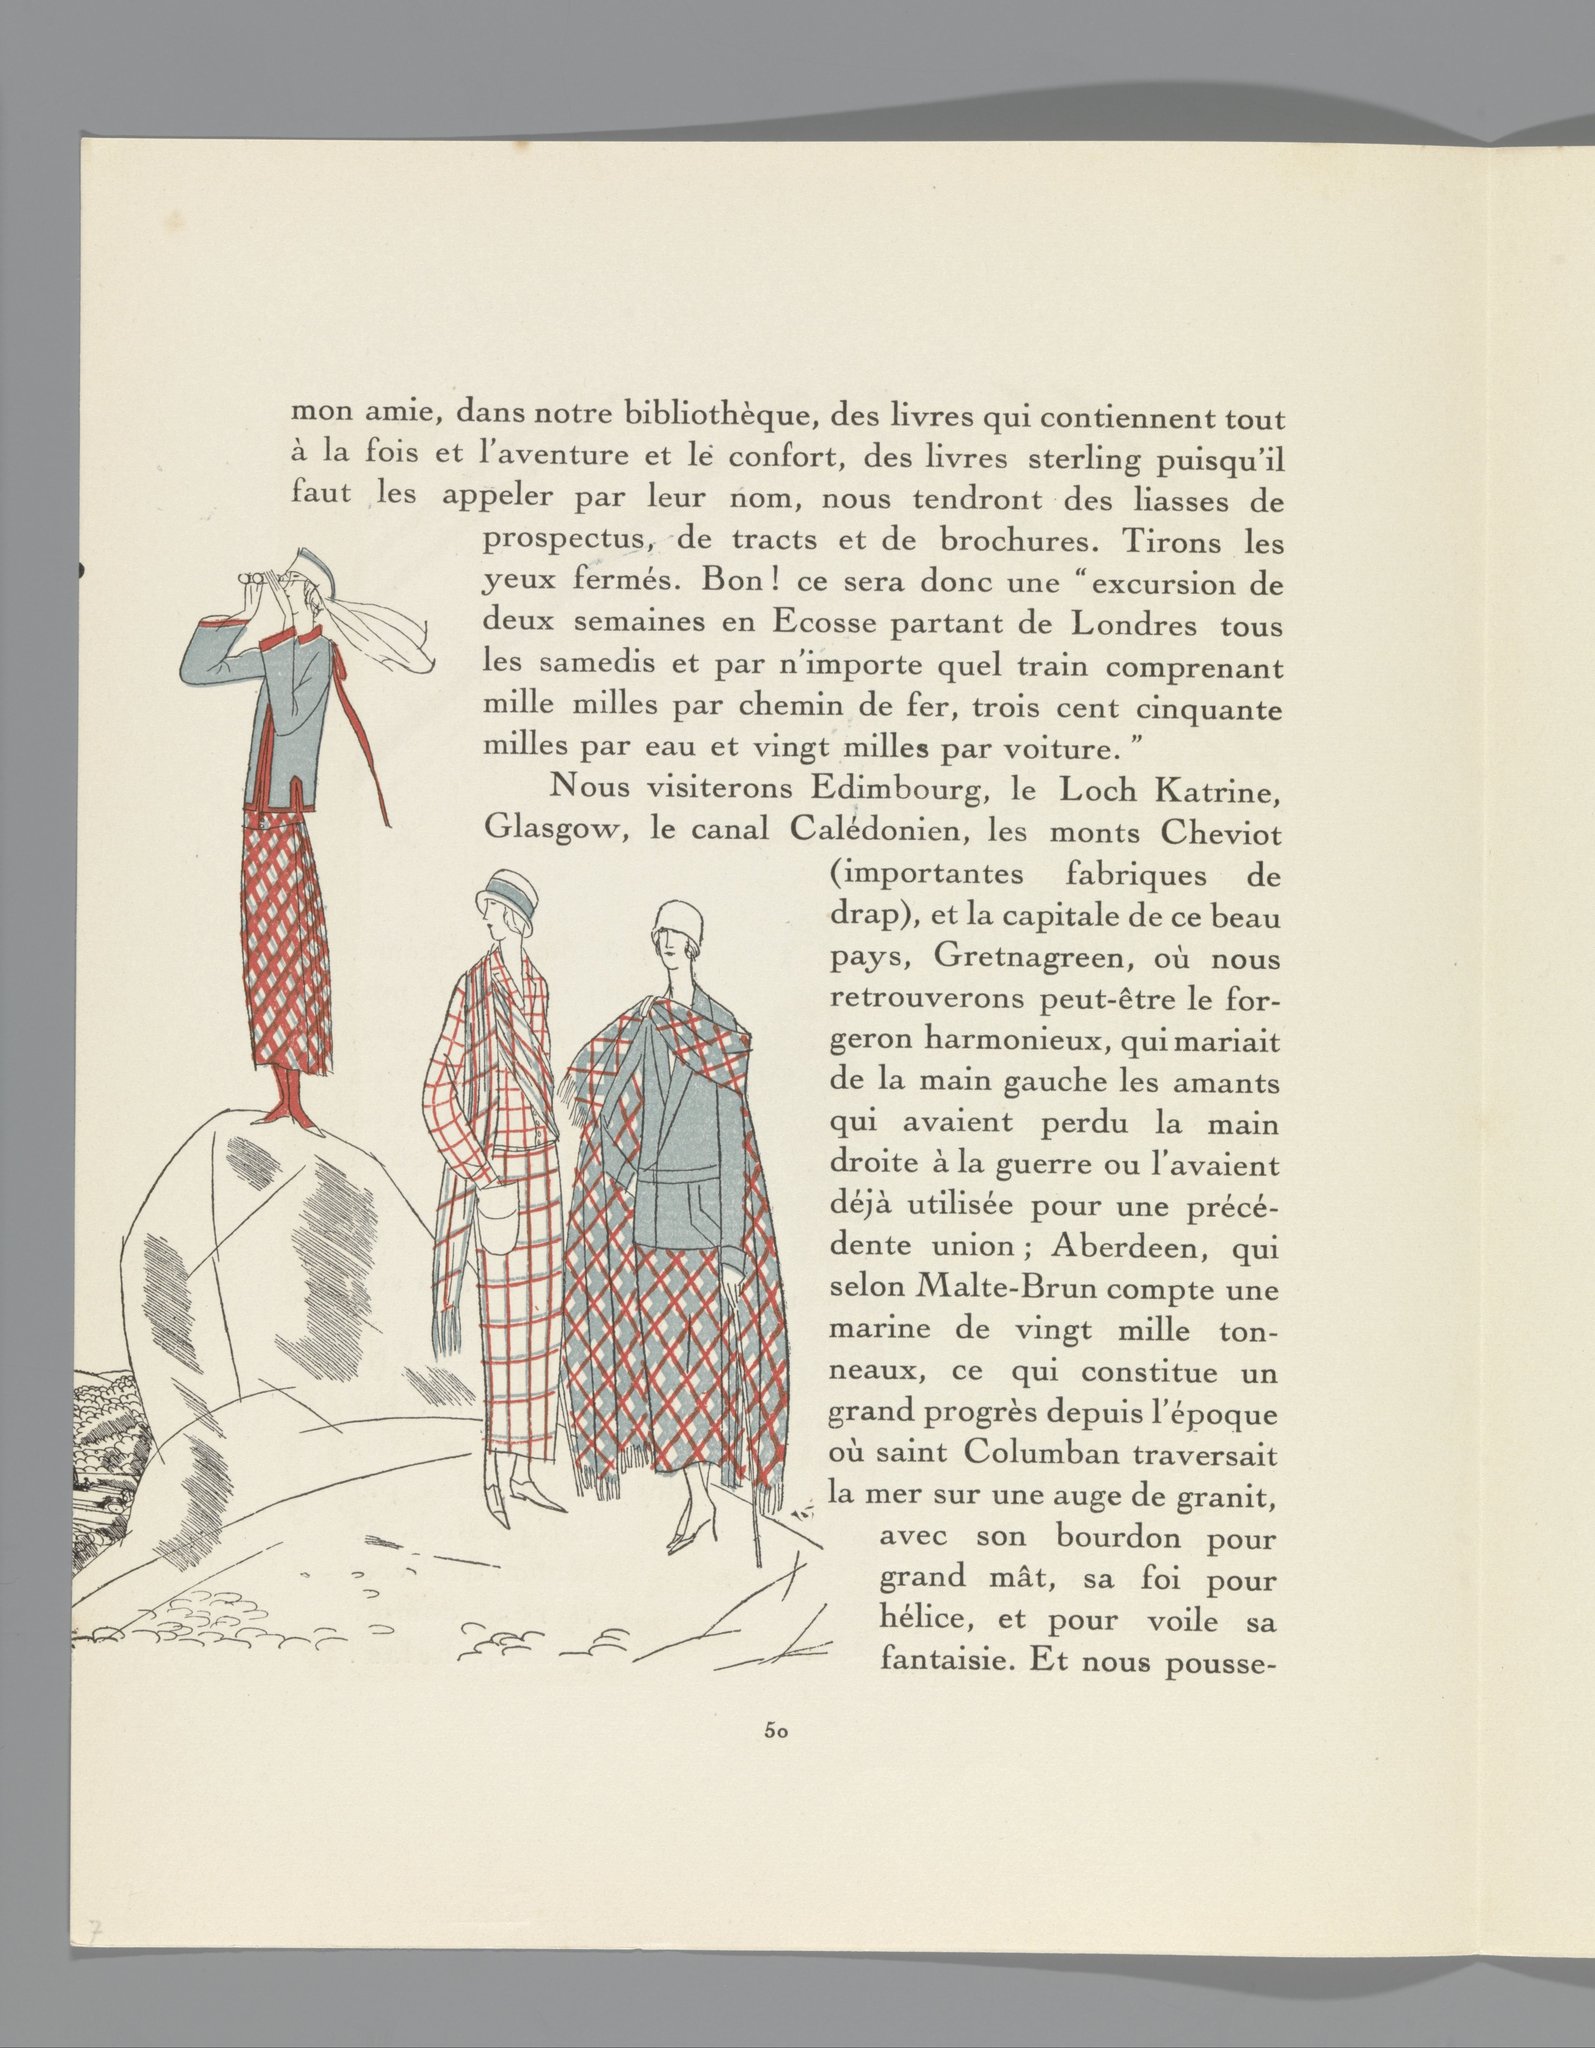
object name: magazine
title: Gazette du Bon Ton, 1923, no. 2, p. 50: La Vogue de l'Écossais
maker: lucien vogel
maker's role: publisher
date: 1923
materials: paper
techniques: letterpress printing, photochemical processes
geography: paris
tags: ensembles of pieces of clothing (tailleur) (+ women's clothes), neck-gear ~ clothing (shawl) (+ women's clothes), walking-stick, staff, fashion plates, head-gear: hat (+ women's clothes), skirt (+ women's clothes)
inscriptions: date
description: Tekst over Schotland en de mode van de schotse ruit. Illustratie: drie vrouwen in sportieve wandelkleding: ensembles in schotse ruit. Een van hen kijkt door een verrekijker.